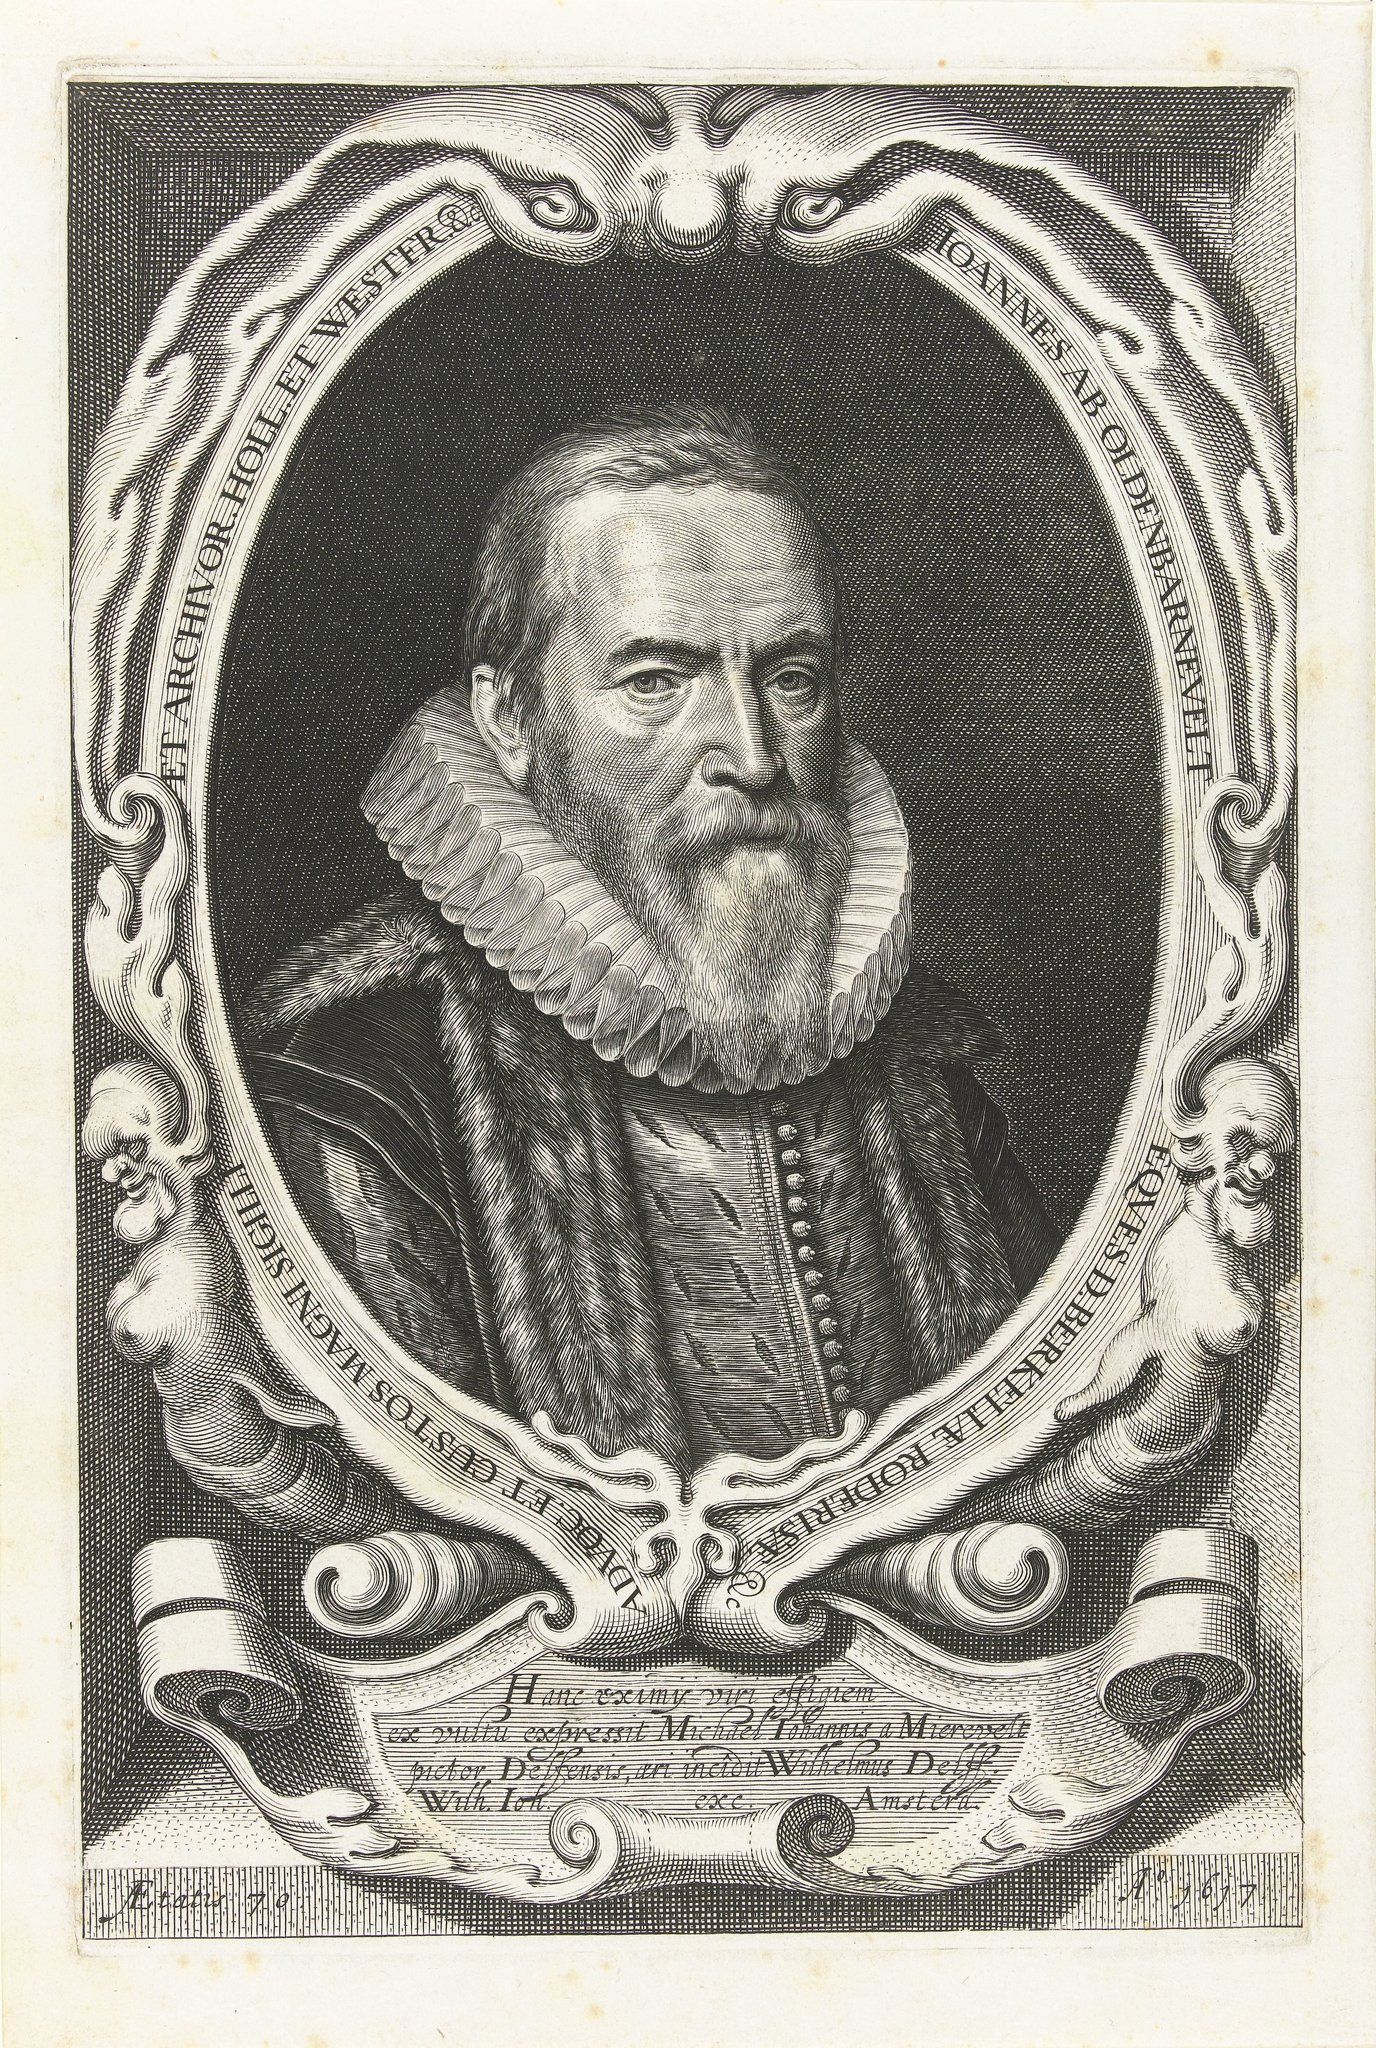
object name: print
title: Portret van Johan van Oldenbarnevelt op 70-jarige leeftijd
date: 1617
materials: paper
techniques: engraving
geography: amsterdam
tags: the hague, johan van oldenbarnevelt, official; civil servant; functionary (in general)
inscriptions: collector's mark: Lugt 2228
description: Portret van Johan van Oldenbarnevelt op 70-jarige leeftijd, borststuk met molenkraag en toga in ovale cartouche met opschrift. Onder portret cartouche met vier regels Latijns opschrift.